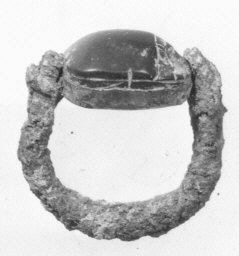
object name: stamp seal ring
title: Scarab seal ring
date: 1700-1560 BCE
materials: copper alloy, gold, jasper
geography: levant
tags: scarabs